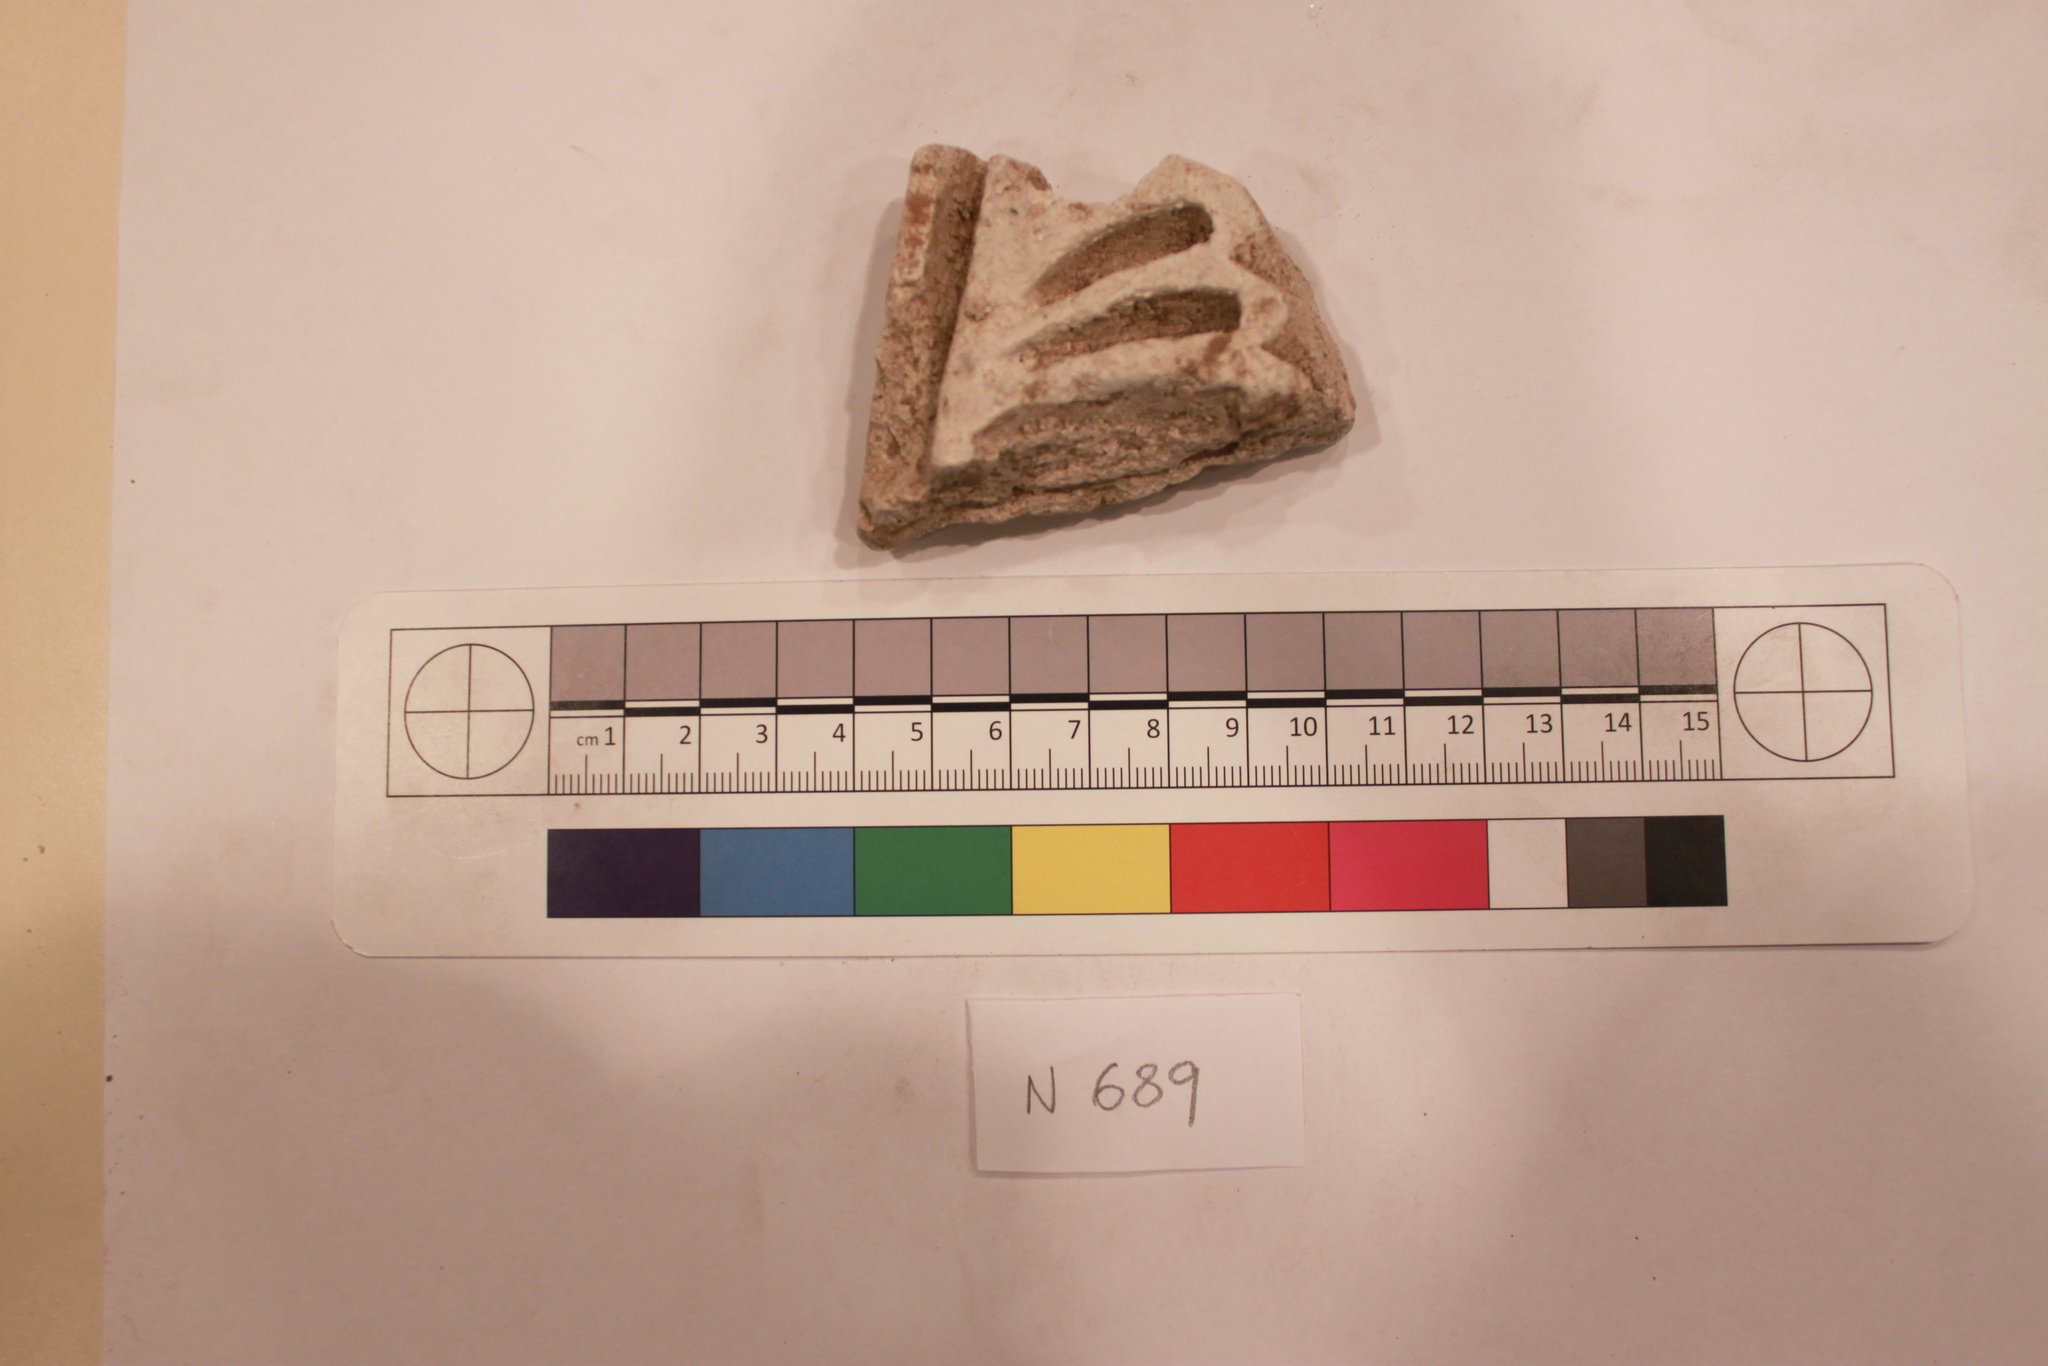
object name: fragment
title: Stucco Fragment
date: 701-1200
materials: plaster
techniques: carving, painting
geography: iran